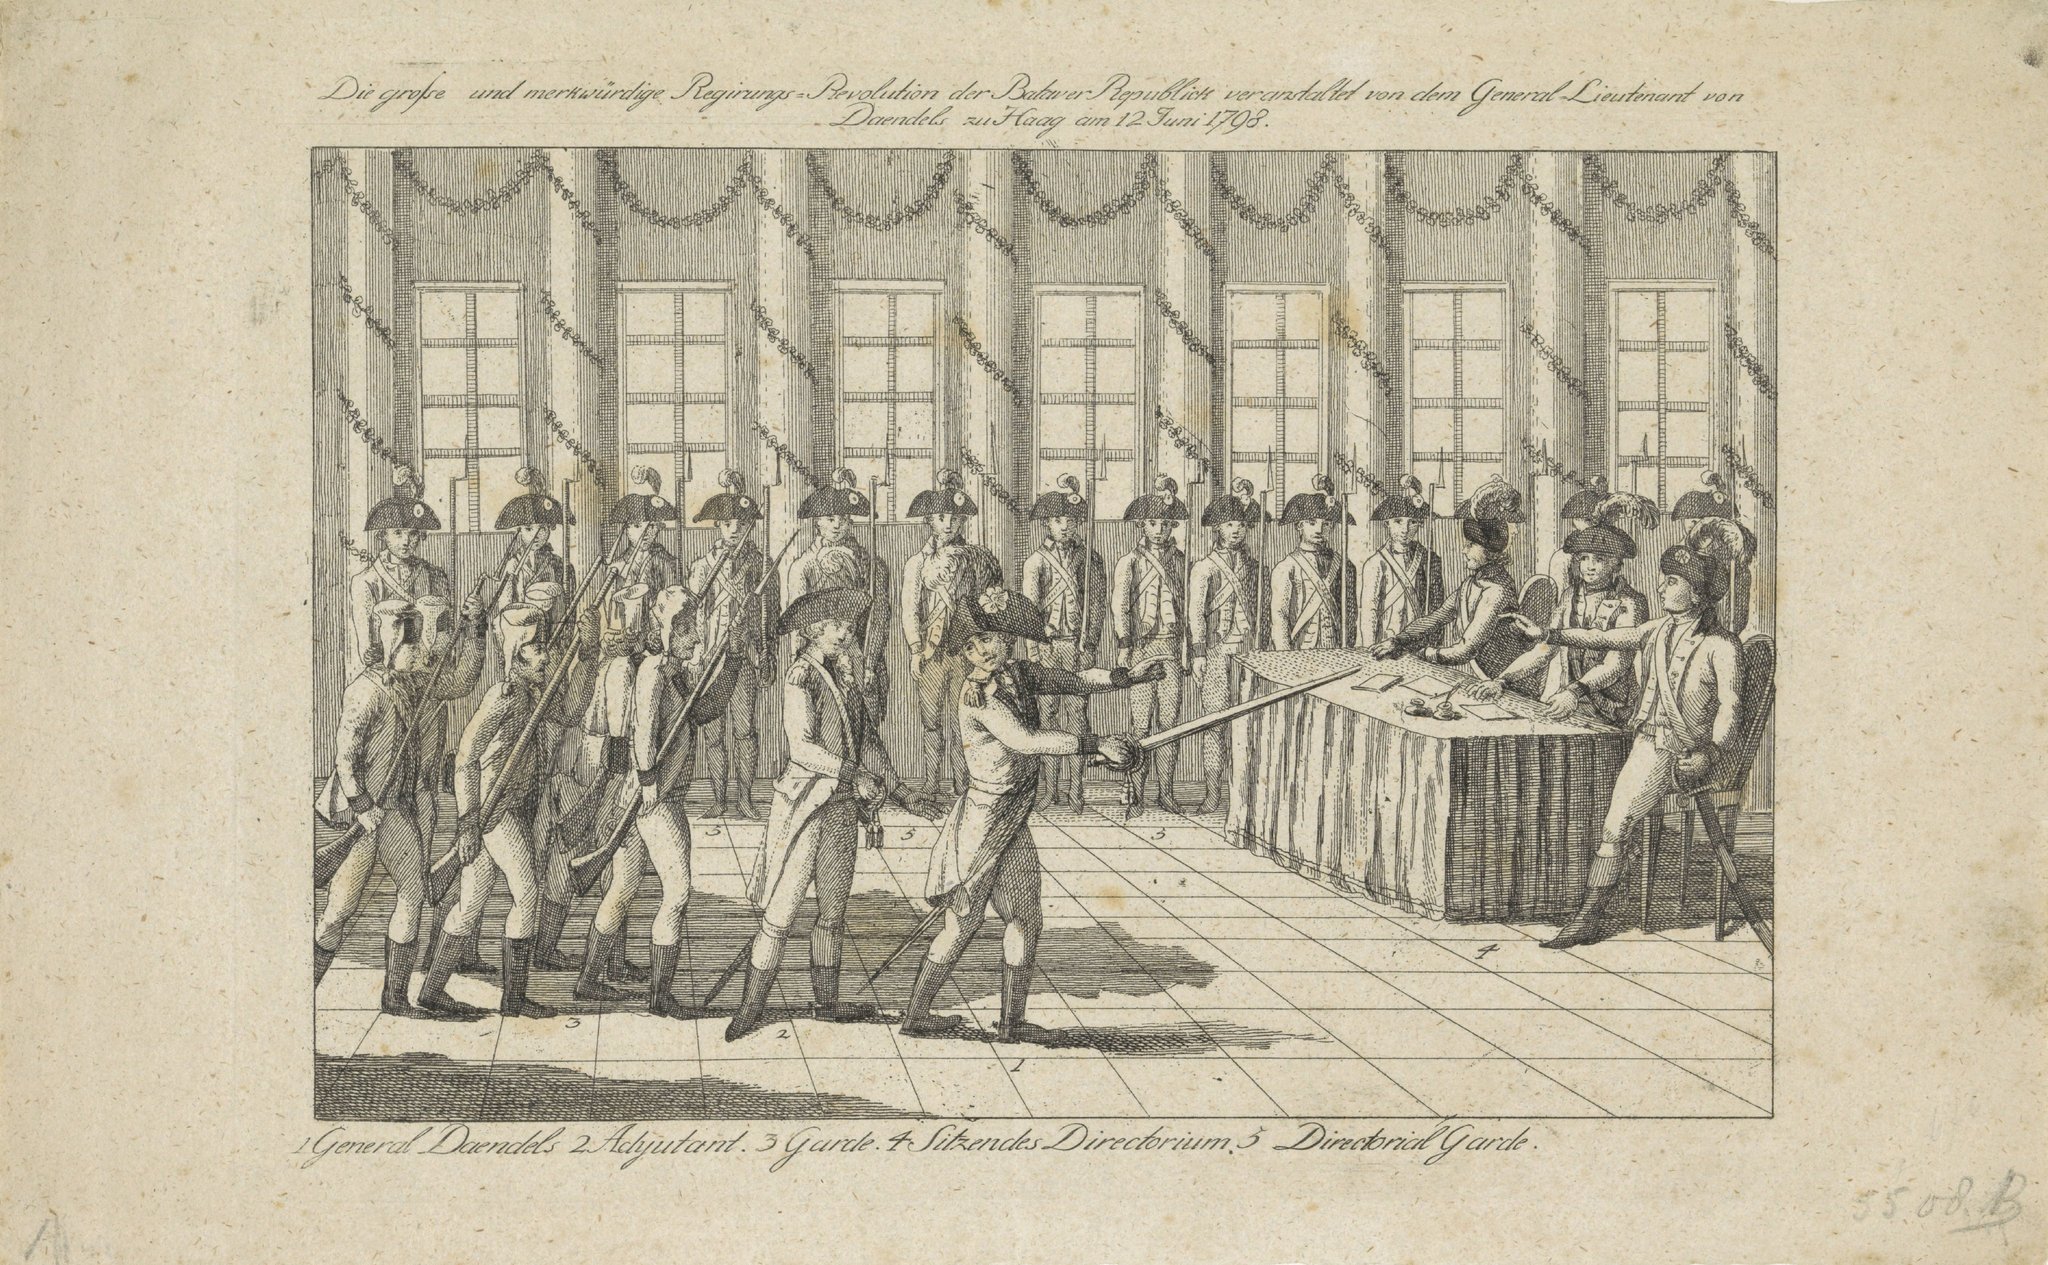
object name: print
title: Die grosse und merkwürdige Regirungs-Revolution der Bataver Republick veranstaltet von dem General Lieutenant von Daendels zu Haag am 12 Juni 1798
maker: Anonymous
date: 1798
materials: paper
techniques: etching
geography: germany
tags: herman willem daendels, revolution, revolt, the hague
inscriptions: collector's mark: Lugt 2228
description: Staatsgreep door militairen onder bevel van generaal Herman Willem Daendels, 12 juni 1798. Daendels valt met een groep militairen een zaal binnen waar drie leden van het Uitvoerend Bewind aan een tafel zitten. Op de achtergrond staat een rij soldaten van de garde.